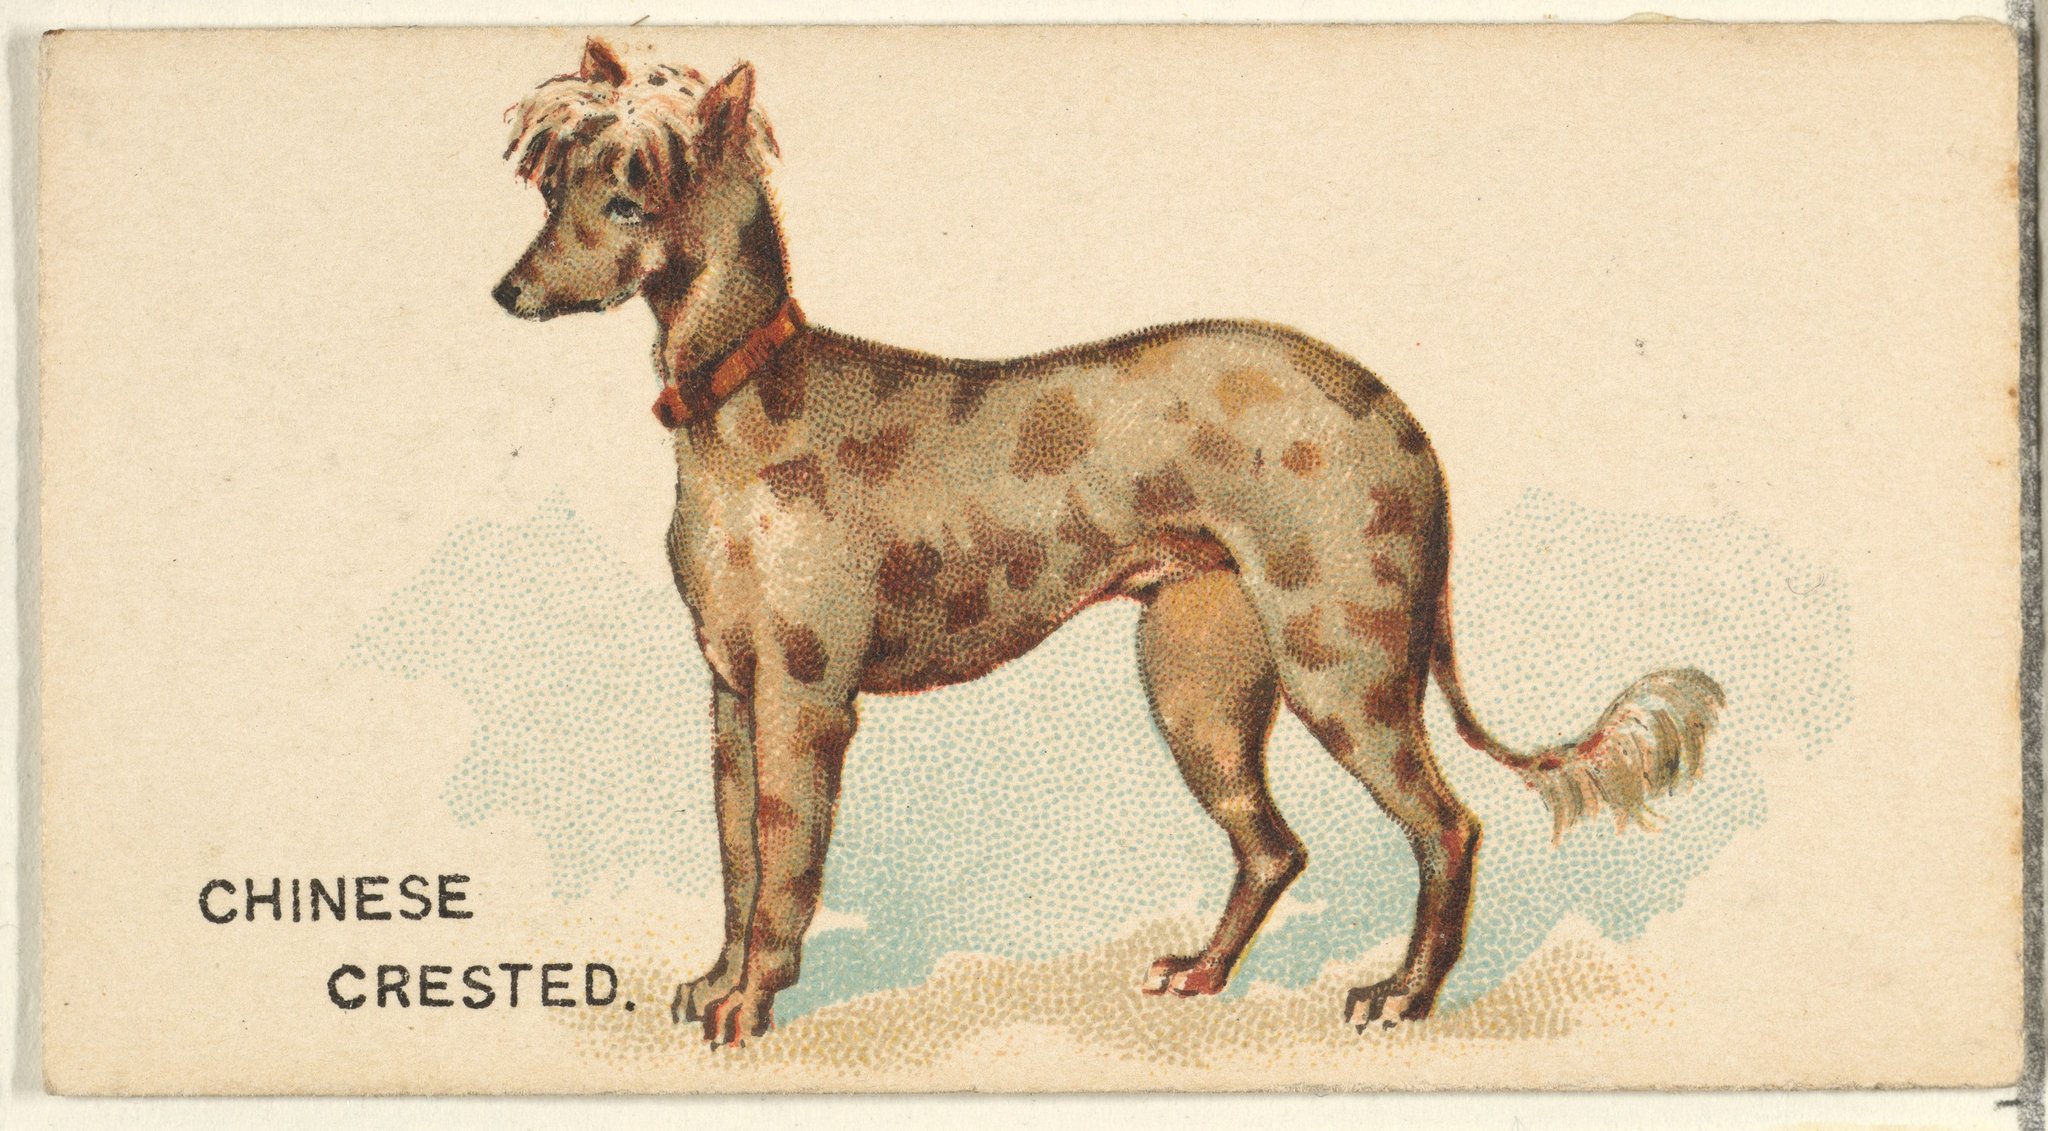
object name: print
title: Chinese Crested, from the Dogs of the World series for Old Judge Cigarettes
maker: goodwin & company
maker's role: publisher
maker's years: 1850-1950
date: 1890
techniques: color lithograph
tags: dogs